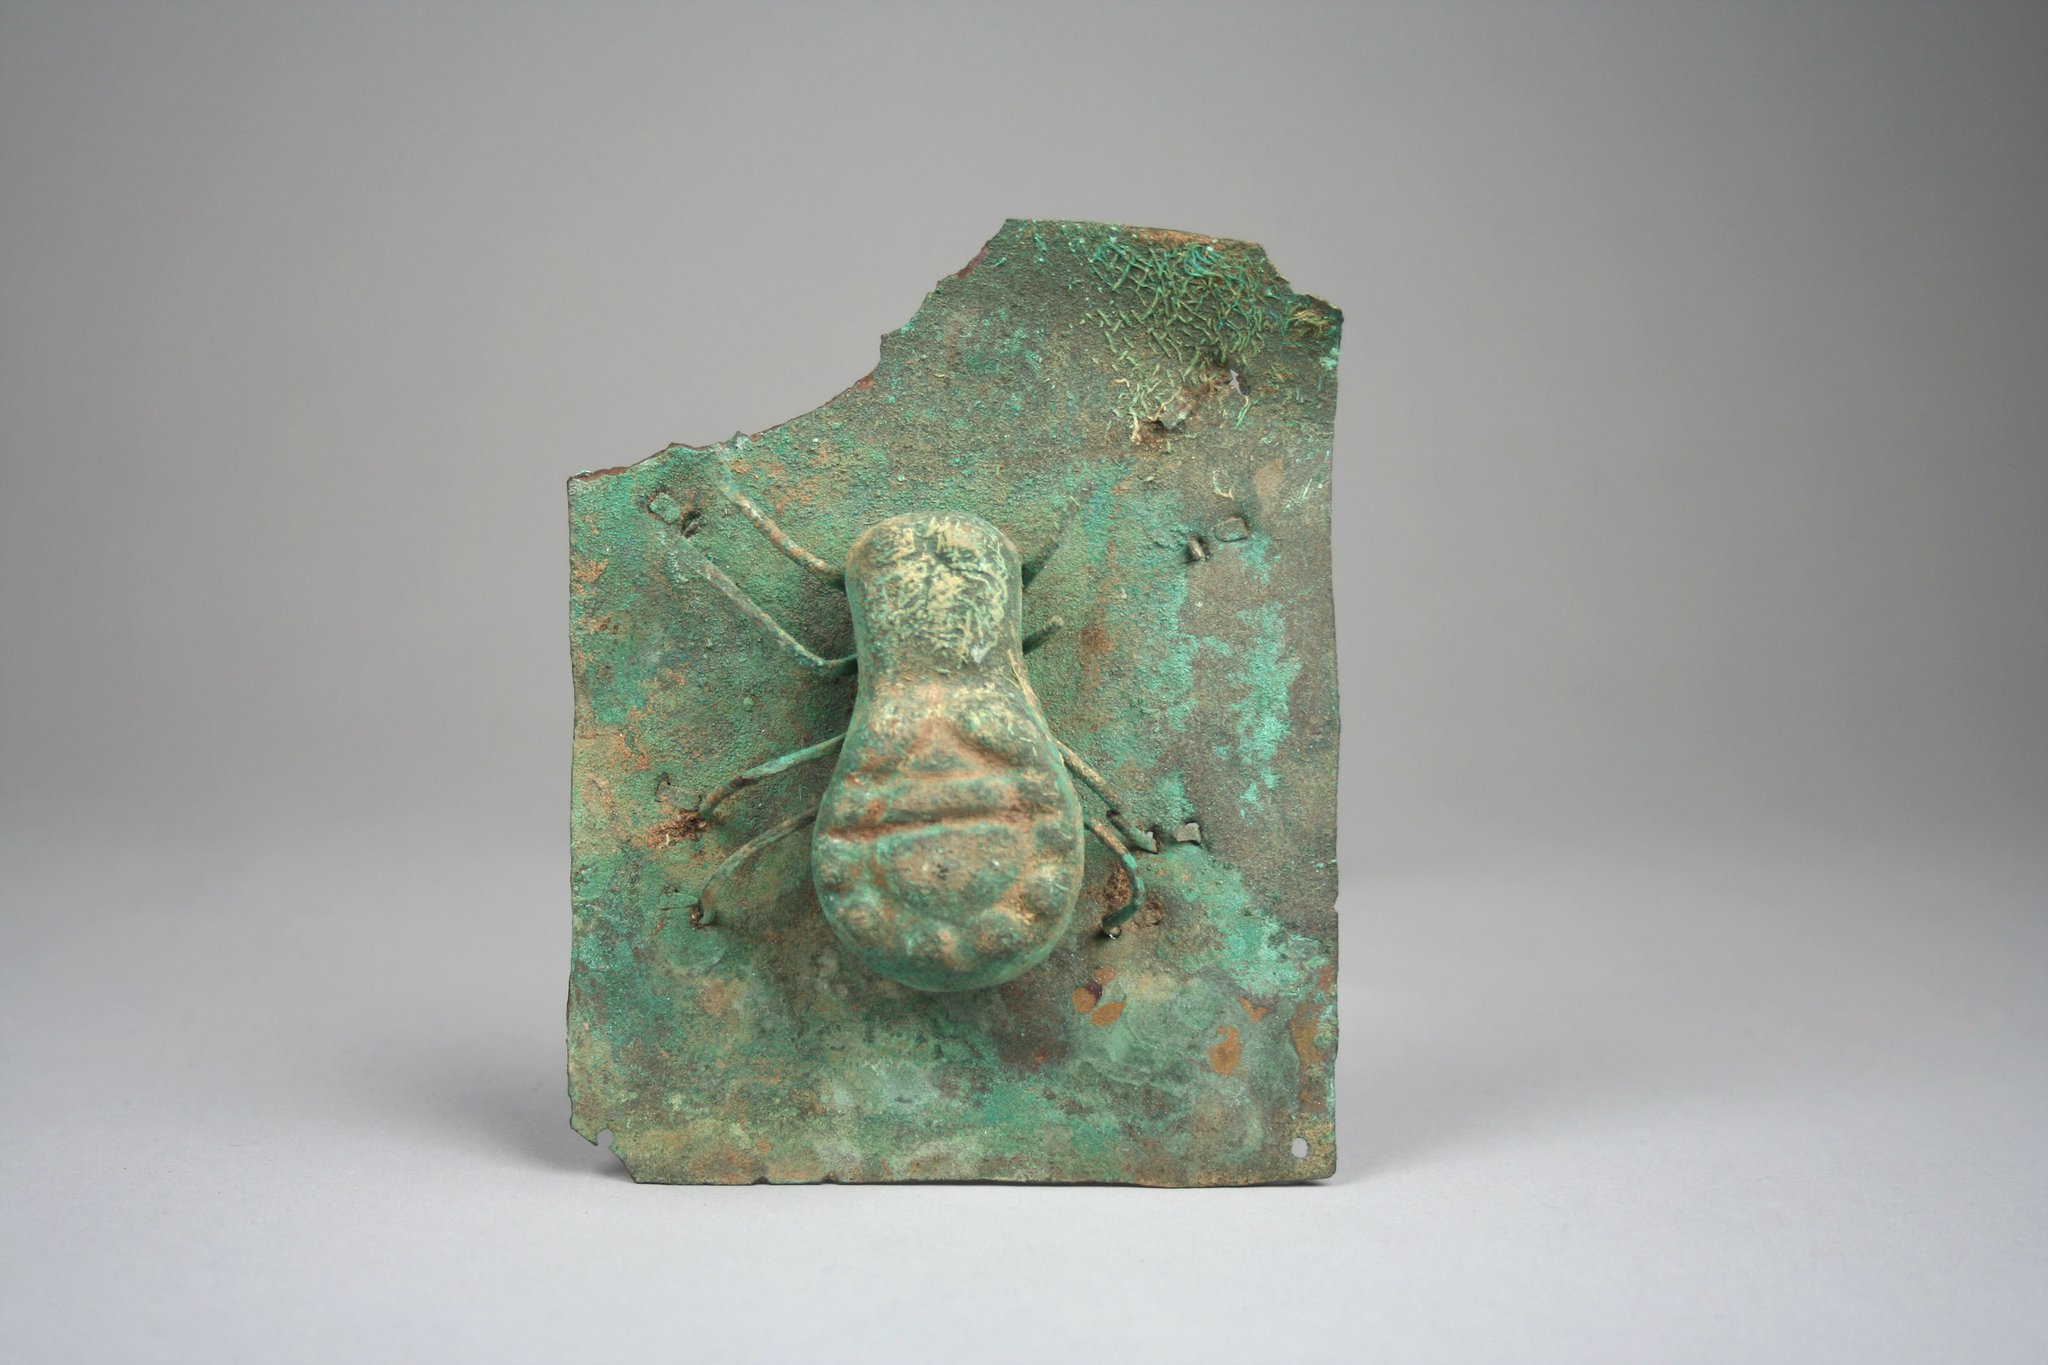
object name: ornament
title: Spider Ornament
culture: moche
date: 501-700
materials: metal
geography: peru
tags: insects